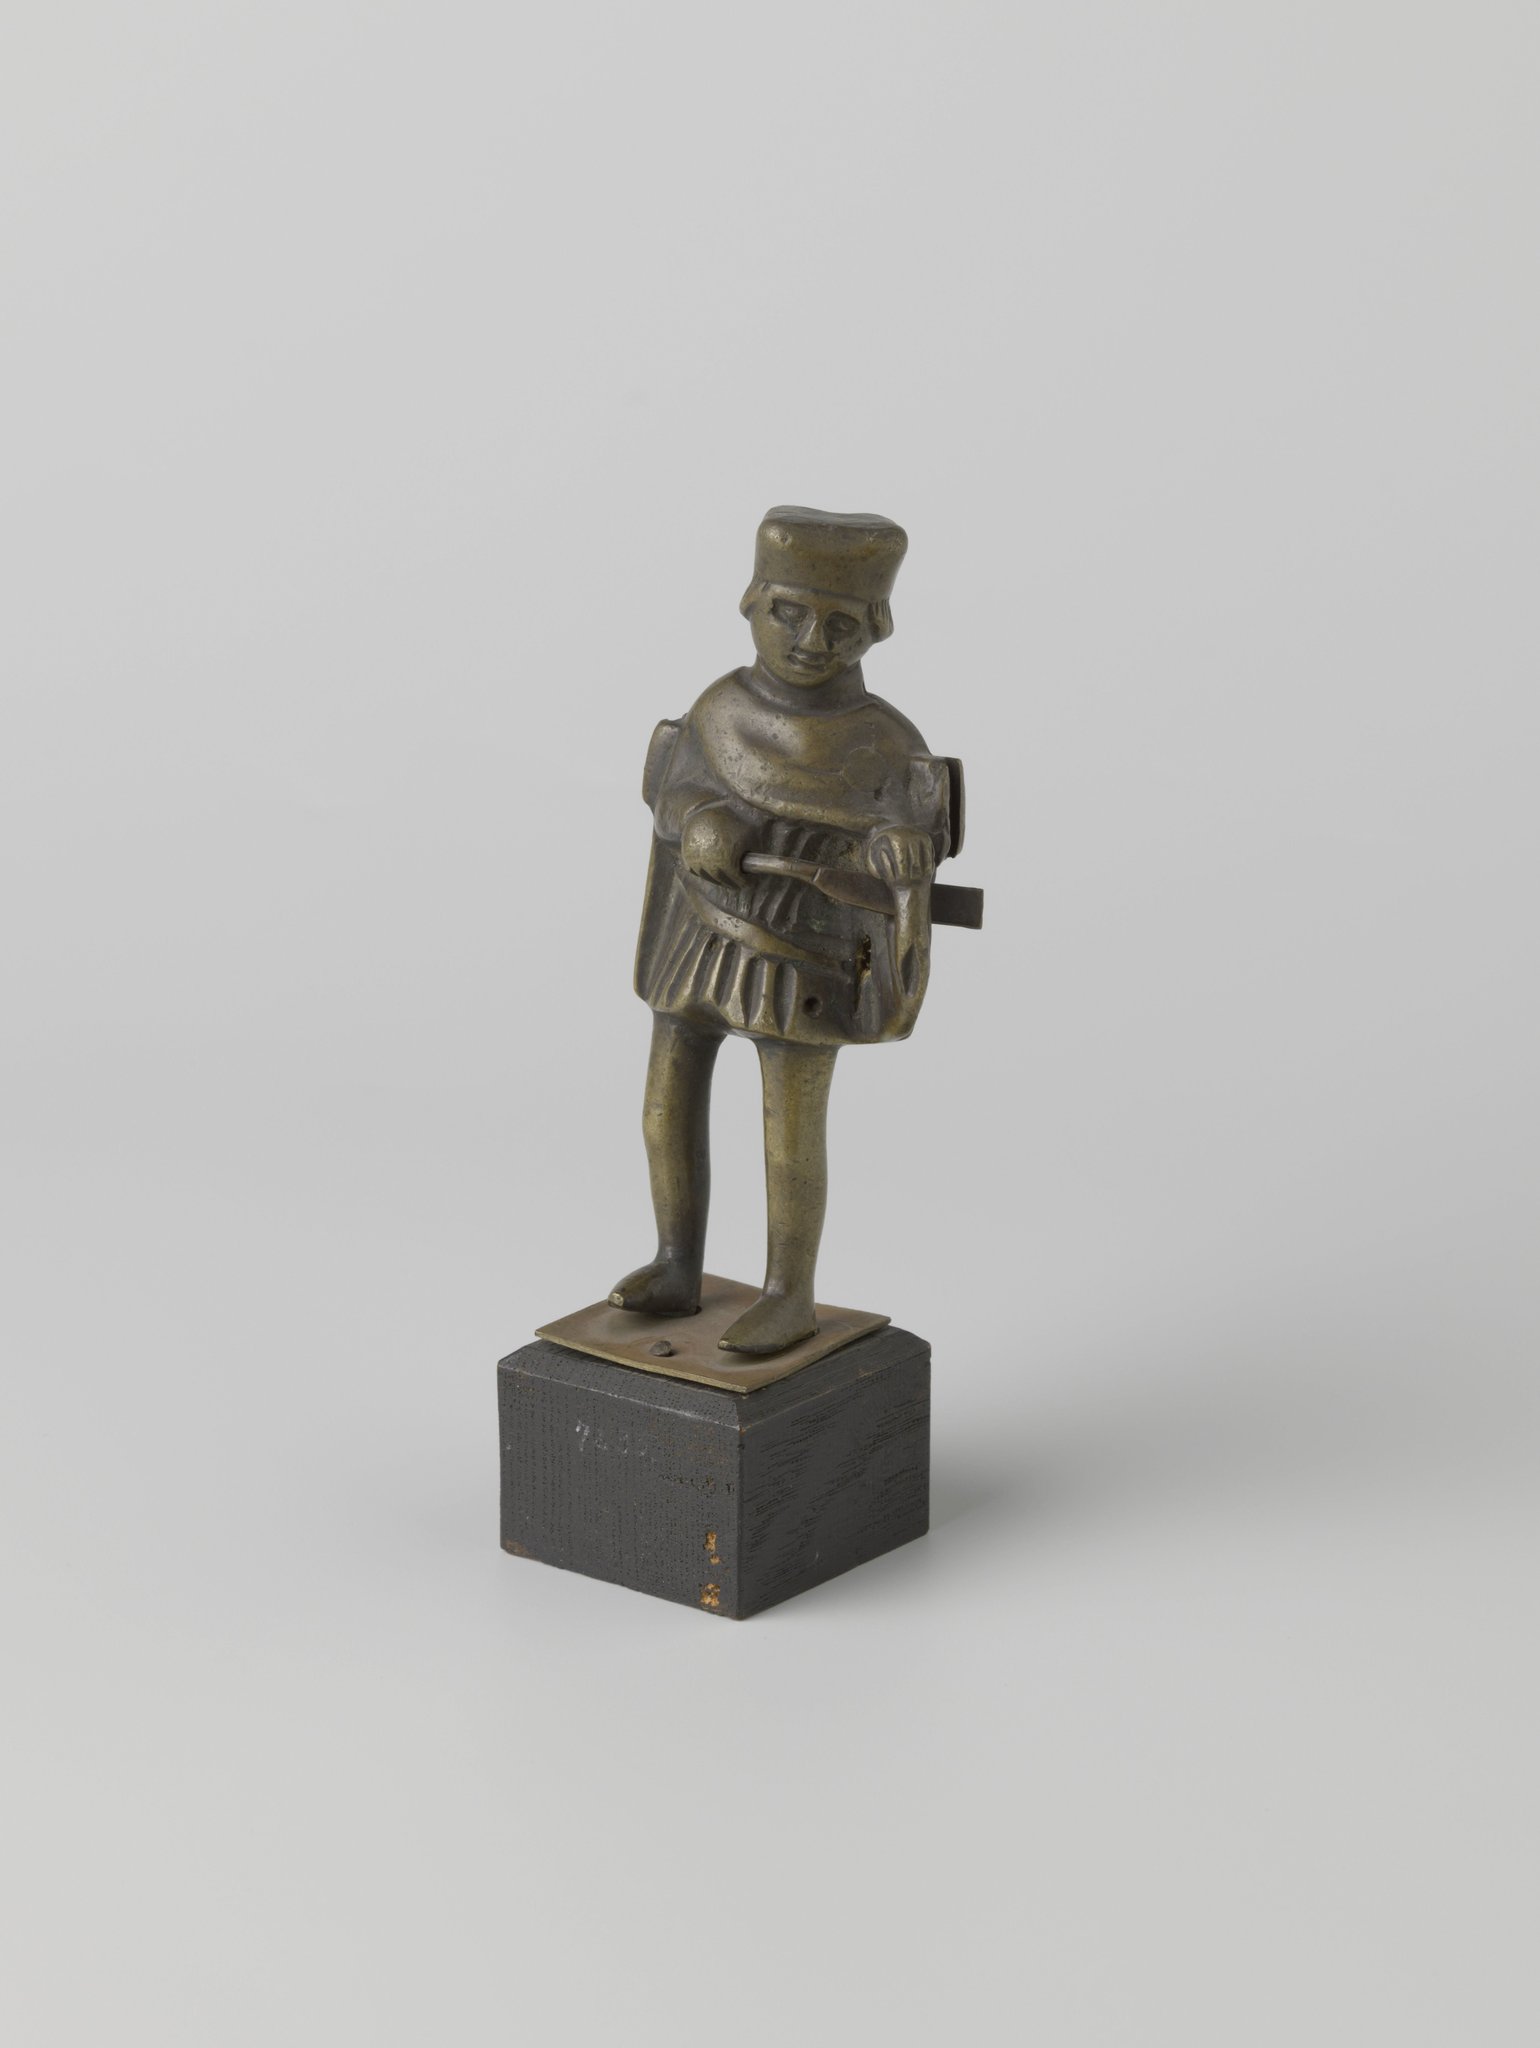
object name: figure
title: Sint Maarten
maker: Anonymous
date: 1500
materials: brass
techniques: casting, metalworking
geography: northern netherlands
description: De staande figuur is uit één stuk gegoten en hier en daar bijgeciseleerd. Hij draagt hozen, een door een gordel omsloten wambuis en een mantel, waarvan hij bezig is een stuk af te snijden. Op zijn hoofd draagt hij een bonnet. Aan weerskanten zijn tegen de bovenarm twee gleuven aangebracht waarin andere onderdelen geplaatst kunnen worden. Het houten voetstuk met het koperen plaatje is van latere tijd. De functie van de figuur is niet bekend.